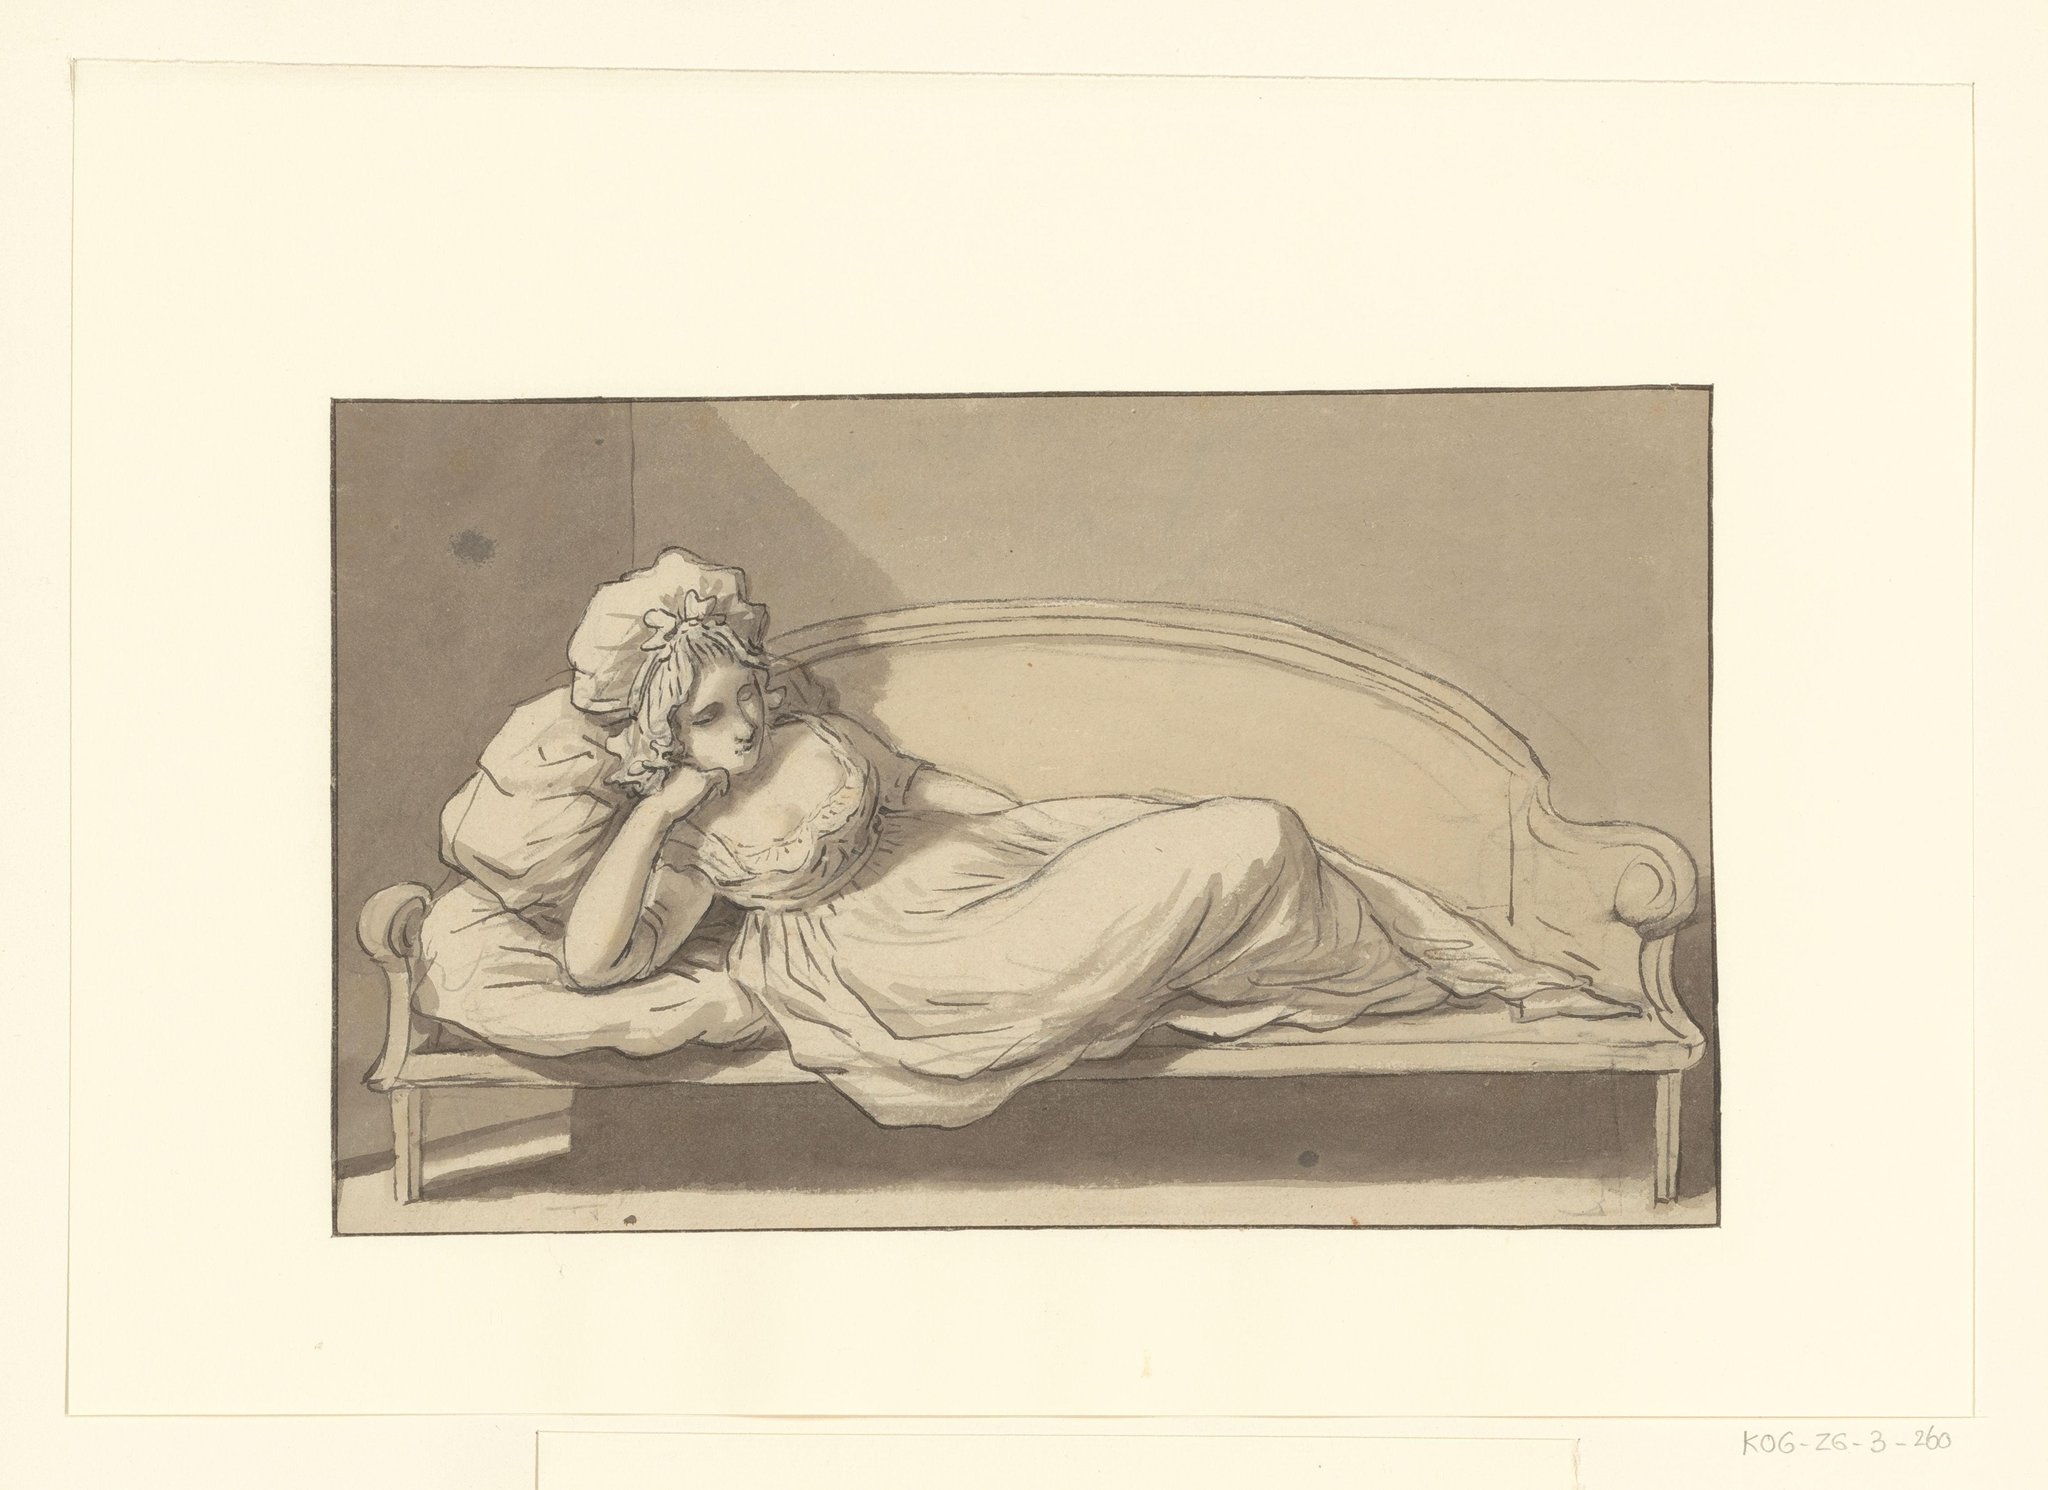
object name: drawing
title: Cornelia Aletta Hulst van ligt op de bank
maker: christiaan andriessen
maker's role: draughtsman, print maker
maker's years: 1775-1846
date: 1800-1810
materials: paint, ink, paper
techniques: brush, pen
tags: lying figure - aa - female human figure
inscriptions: collector's mark: Lugt 1641, collector's mark: Lugt 1641a